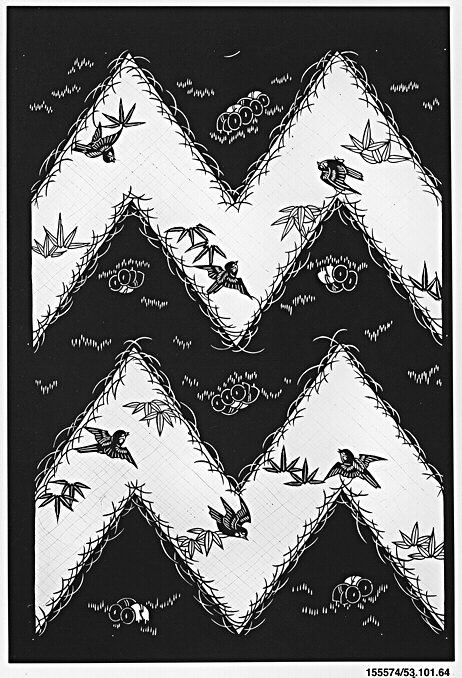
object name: stencil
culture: japanese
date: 1615-1868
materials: paper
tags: birds